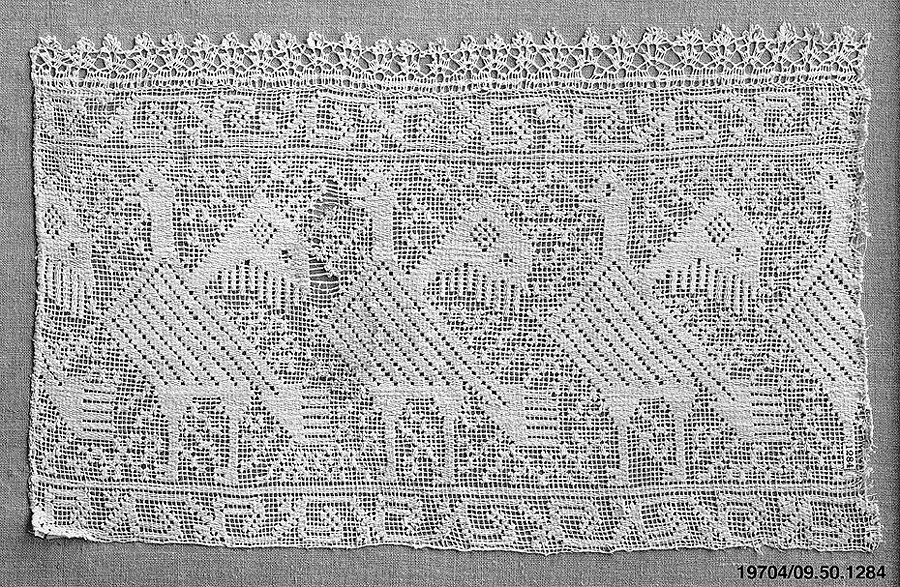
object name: border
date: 1501-1700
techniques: embroidery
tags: birds